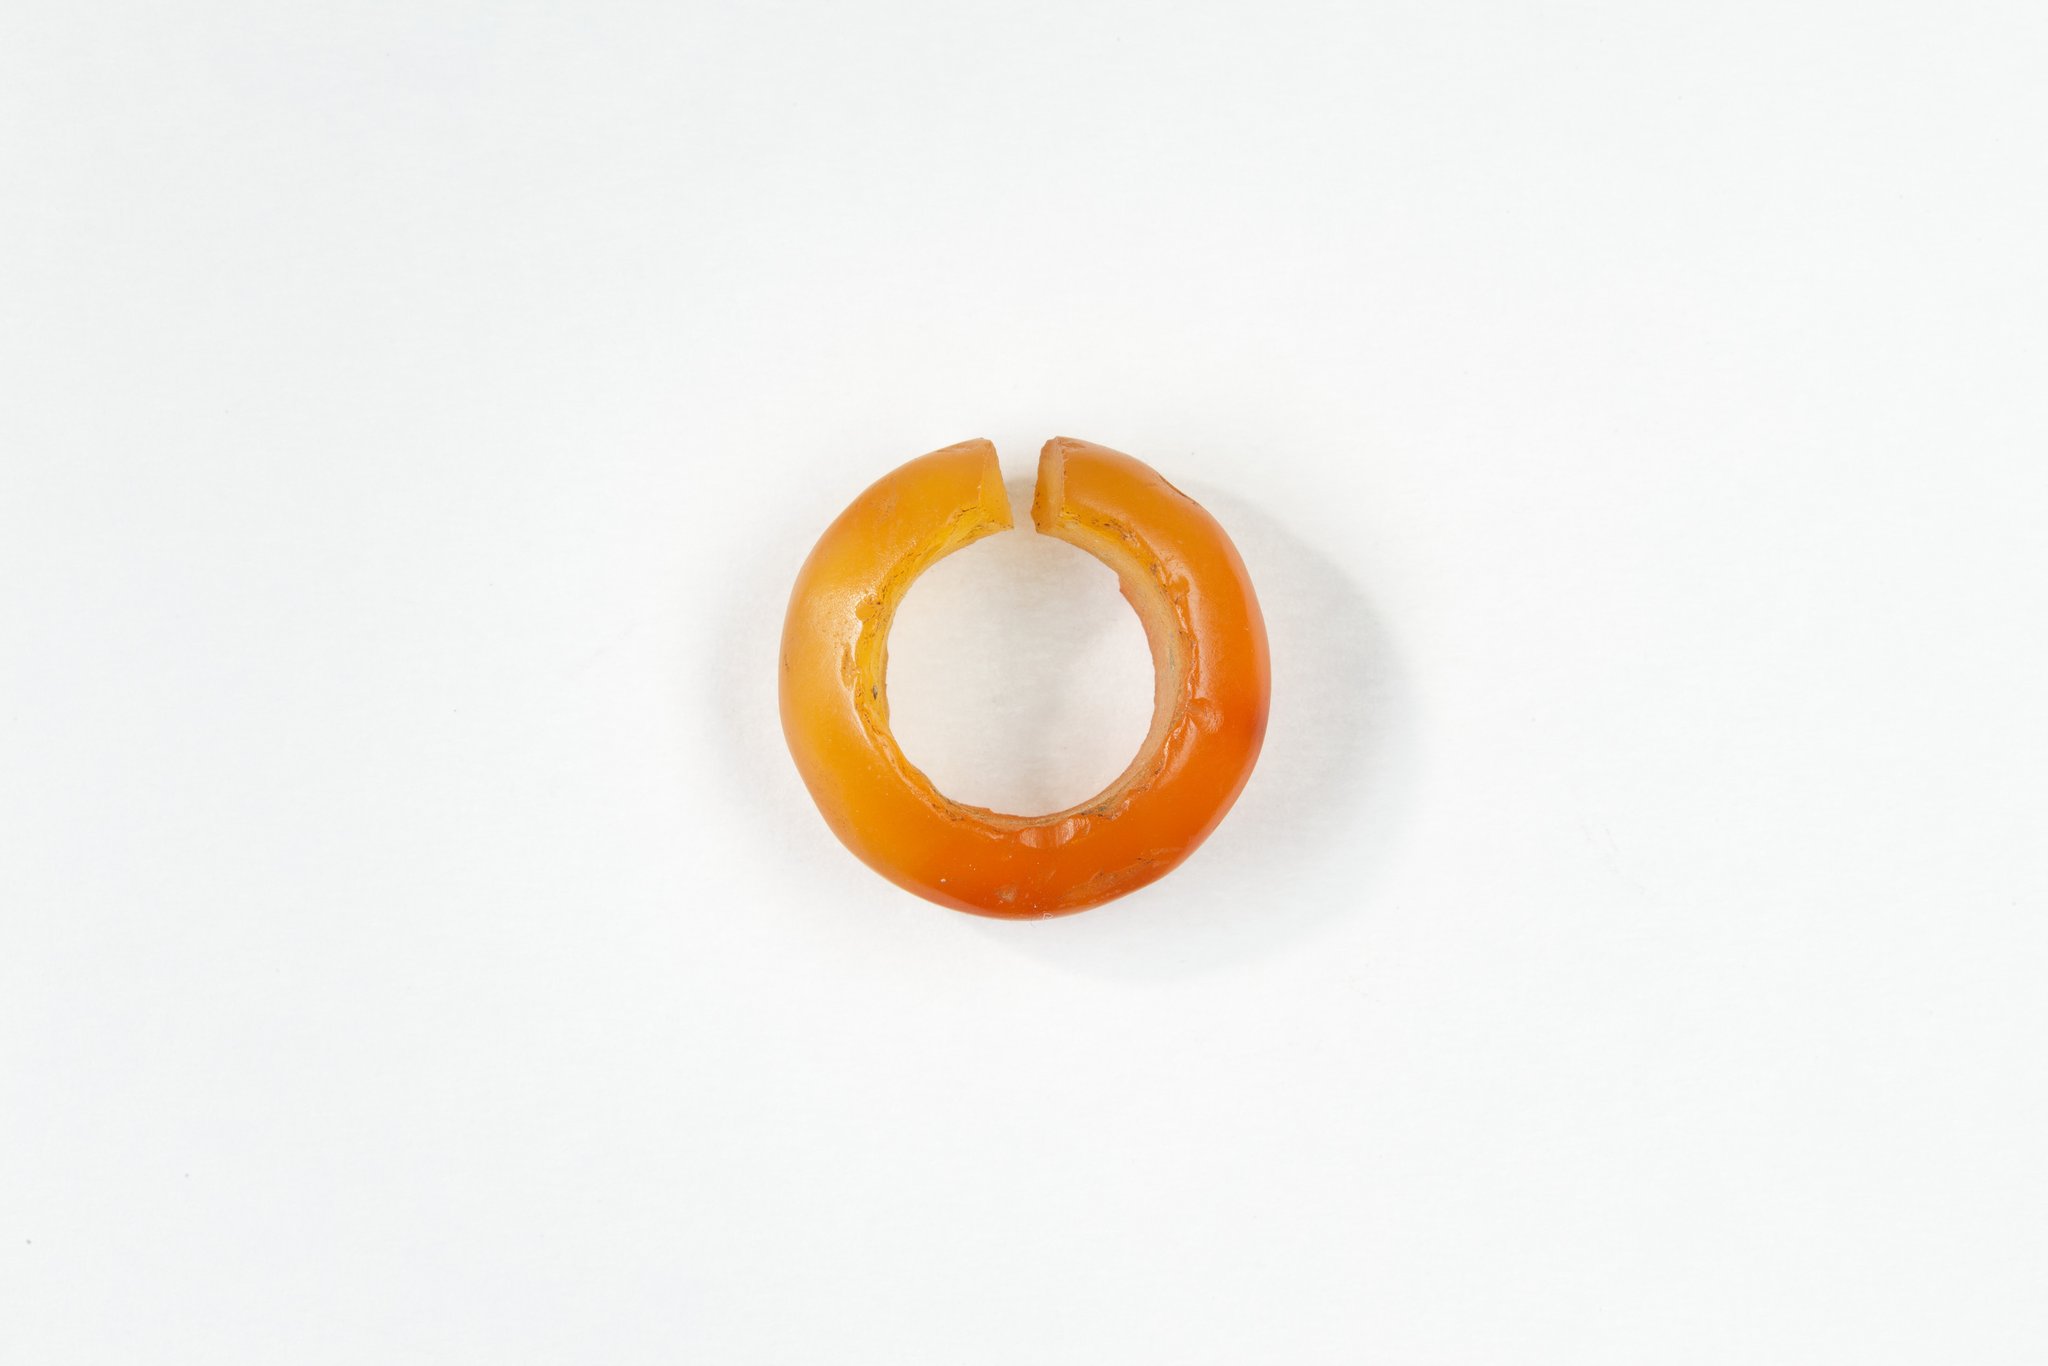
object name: earring, penannular, circular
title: Penannular Earring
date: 1550-1295 BCE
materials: gemstone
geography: northern upper egypt